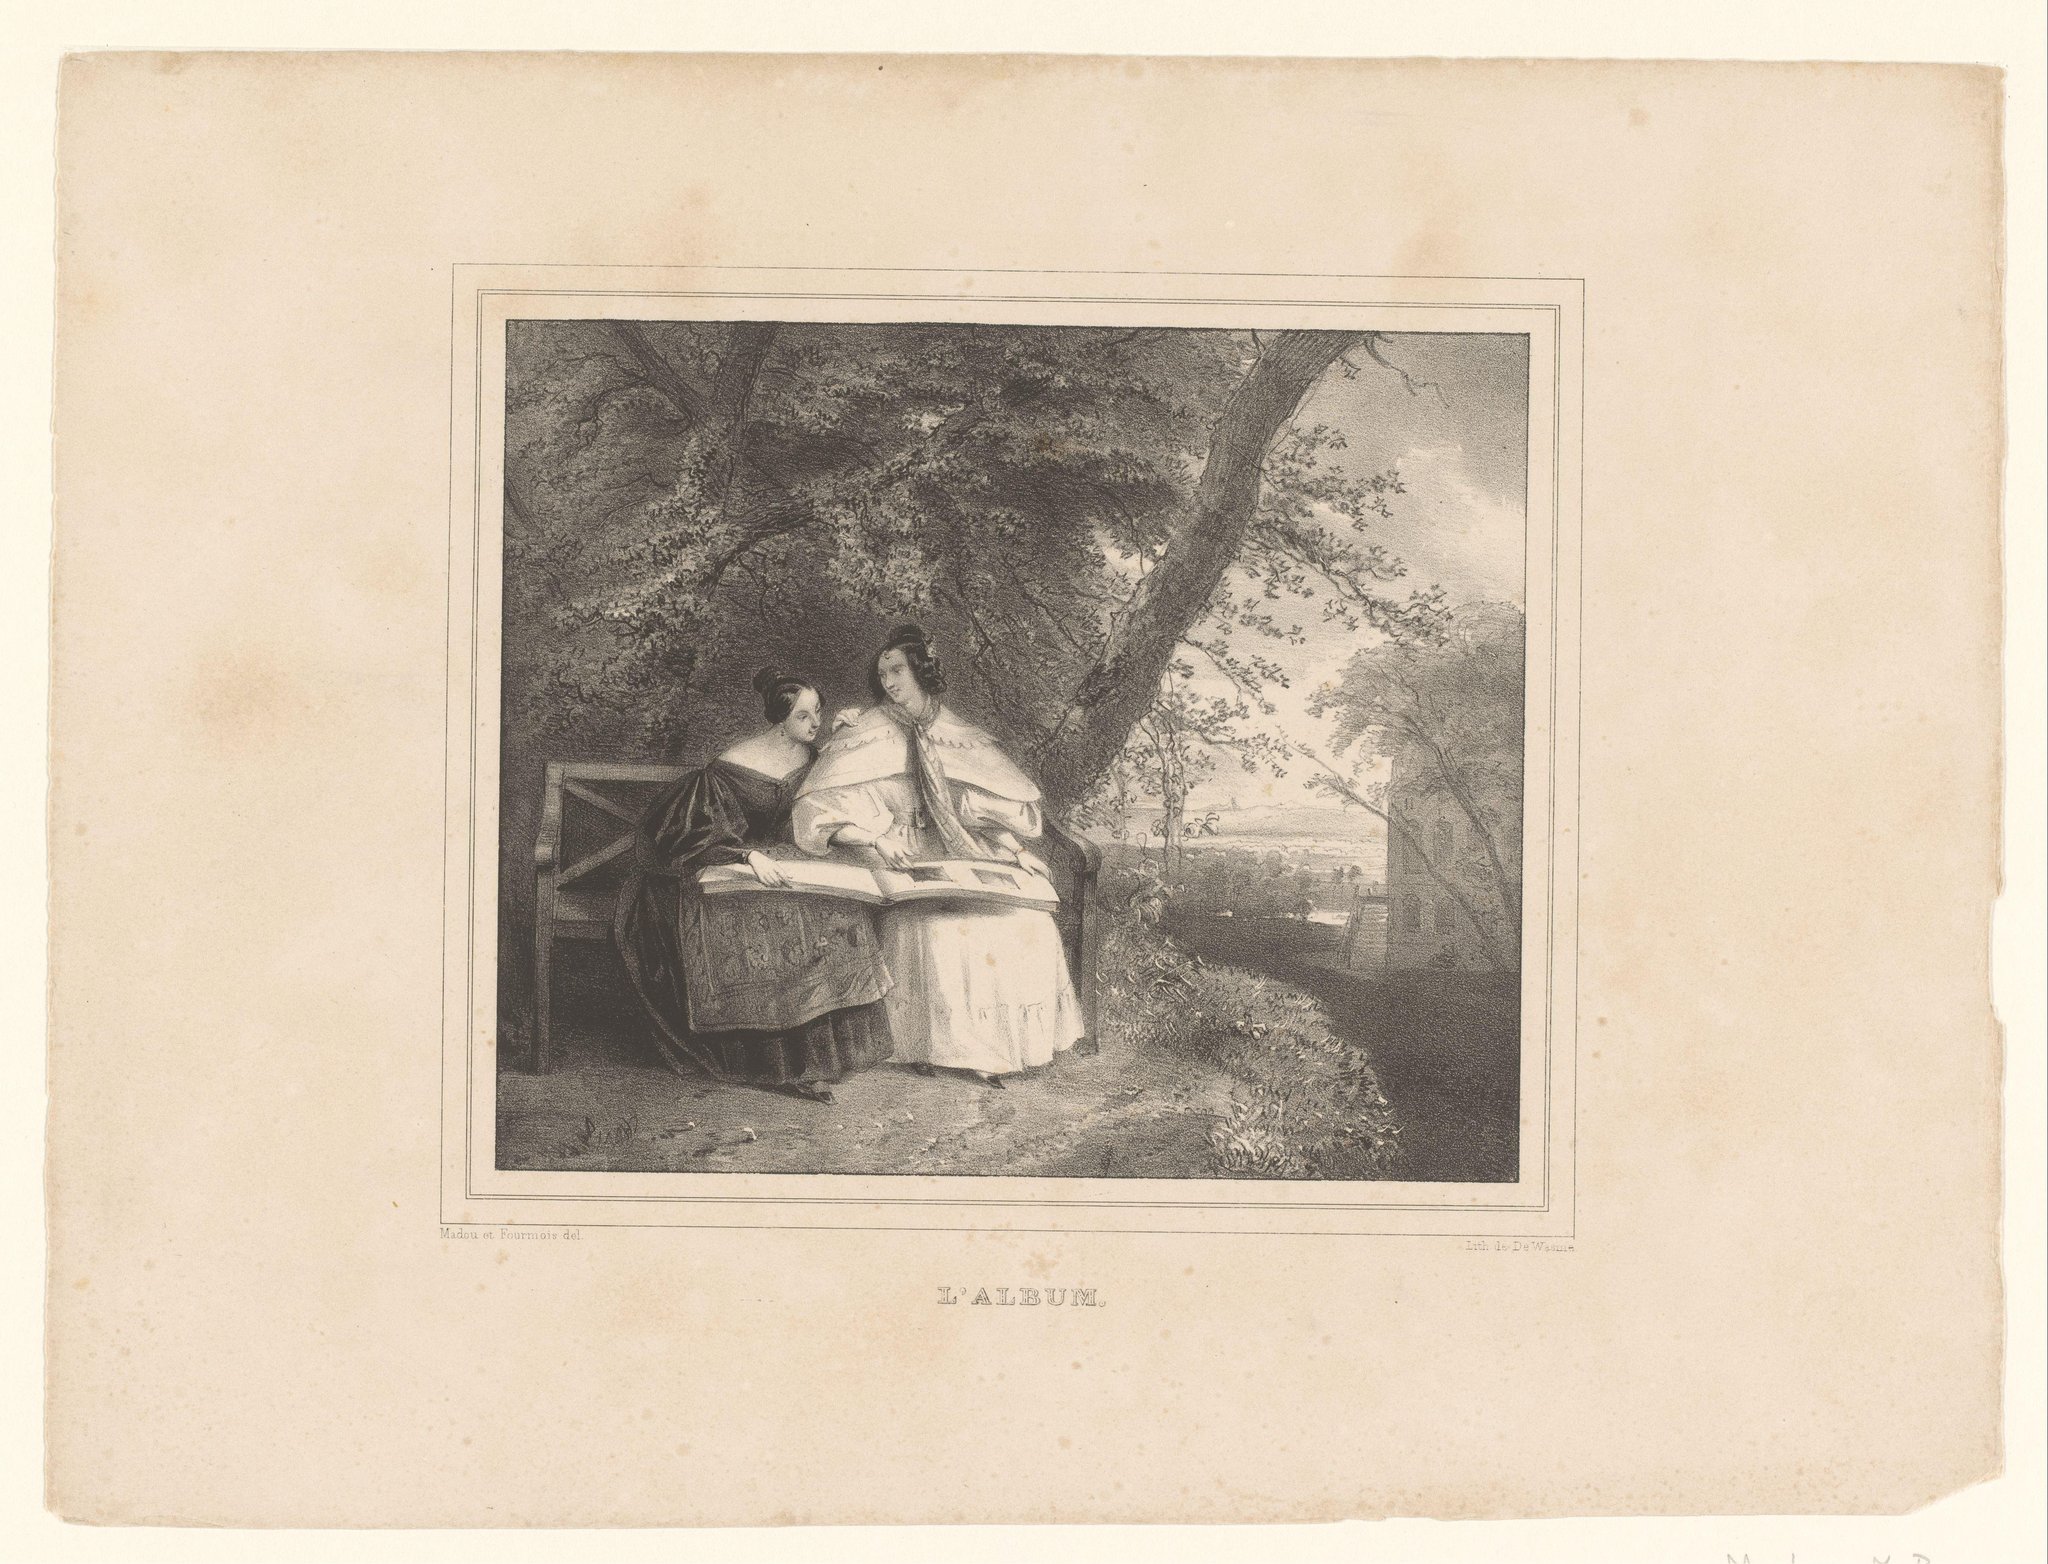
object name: print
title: Landschap met twee vrouwen op een bank die een album bekijken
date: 1834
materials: paper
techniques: lithograph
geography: brussels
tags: bench, landscapes, book - mm - book open, adult woman (+ two persons)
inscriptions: collector's mark: Lugt 2228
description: Prent behoort tot een serie met twaalf genretaferelen vervaardigd door Madou en Fourmois. Vier prenten zijn enkel door Madou vervaardigd en de overige prenten door Madou en Fourmois samen. Madou vervaardigde de figuren en Fourmois het landschap.